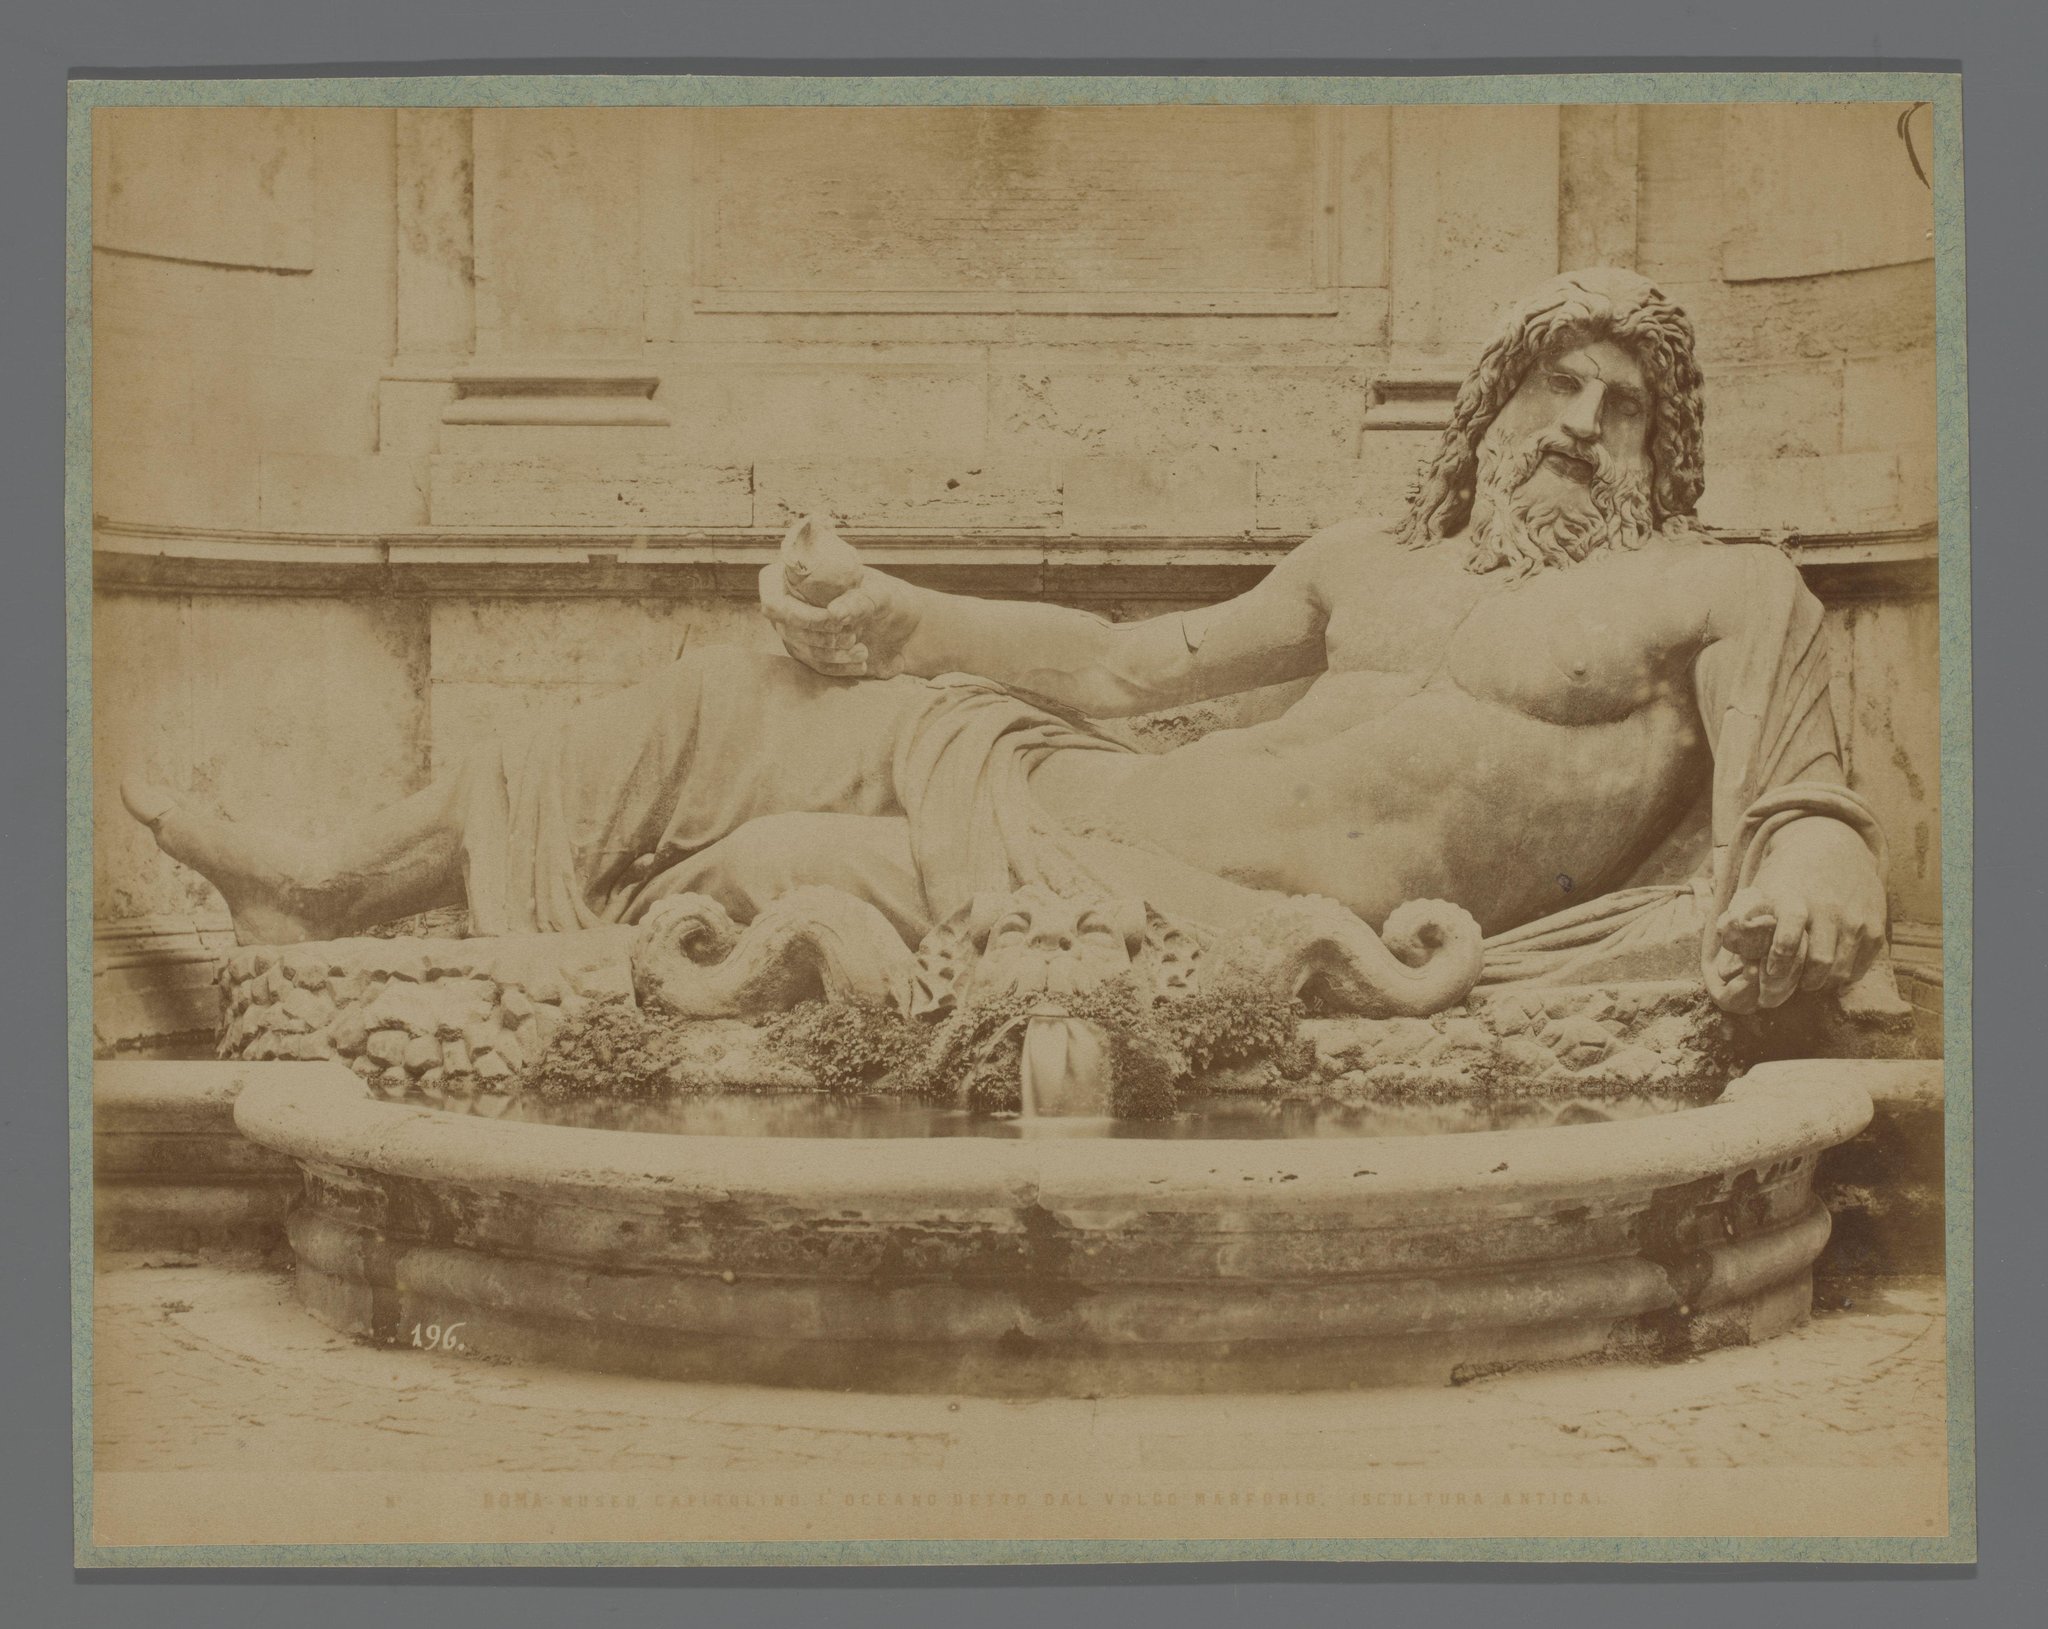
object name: photograph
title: Roma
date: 1852-1900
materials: cardboard, paper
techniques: albumen print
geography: rome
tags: piece of sculpture, reproduction of a piece of sculpture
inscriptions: number: ‘196’, collector's mark: ‘VOSMAER’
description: De fontein van Marforio is een van de zes sprekende standbeelden van Rome waar de inwoners van de stad vanaf de zestiende eeuw hun politieke commentaar konden uiten door middel van plakkaten.